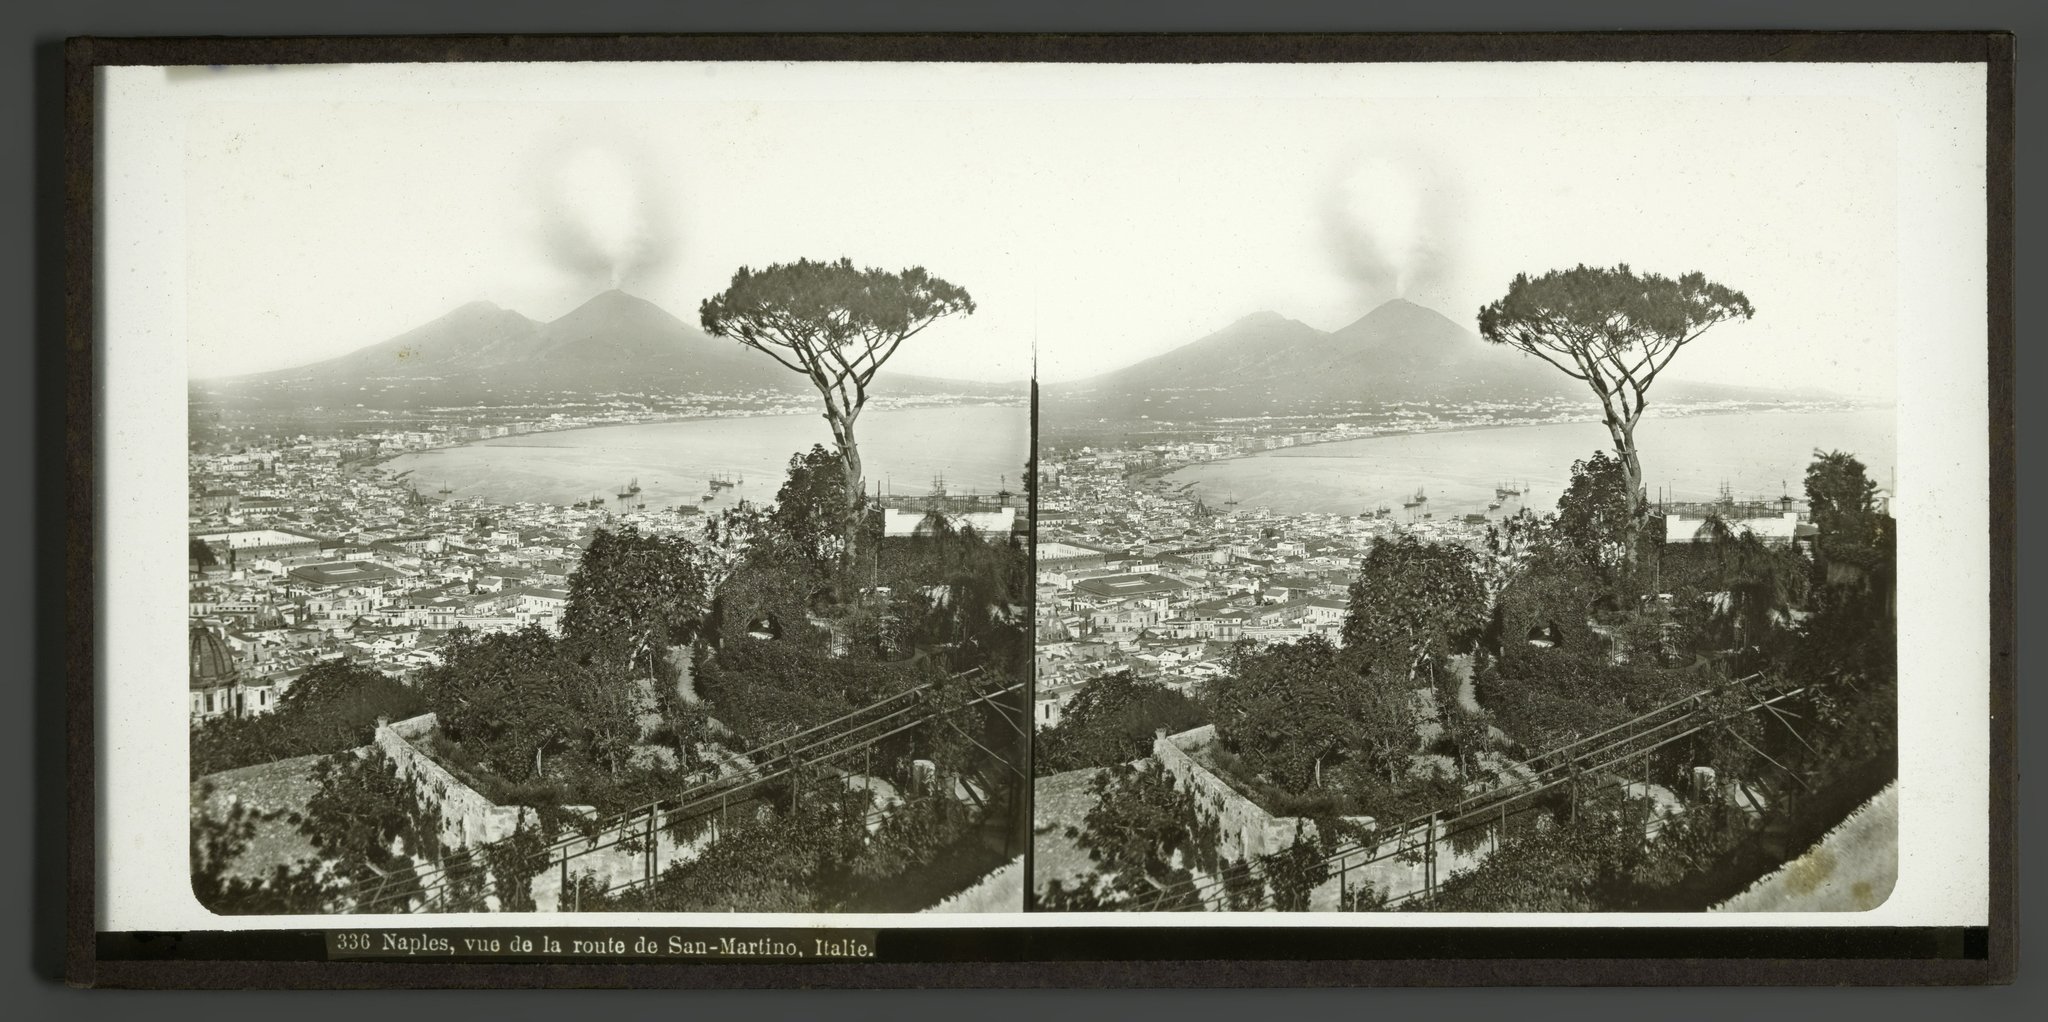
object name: stereoscopic photograph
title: Gezicht op Napels en de Vesuvius, Italië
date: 1860-1870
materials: glass, paper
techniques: slide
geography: naples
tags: canals, waters (in city), prospect of city, town panorama, silhouette of city, mountains, mount vesuvius, naples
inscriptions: number: ‘336’